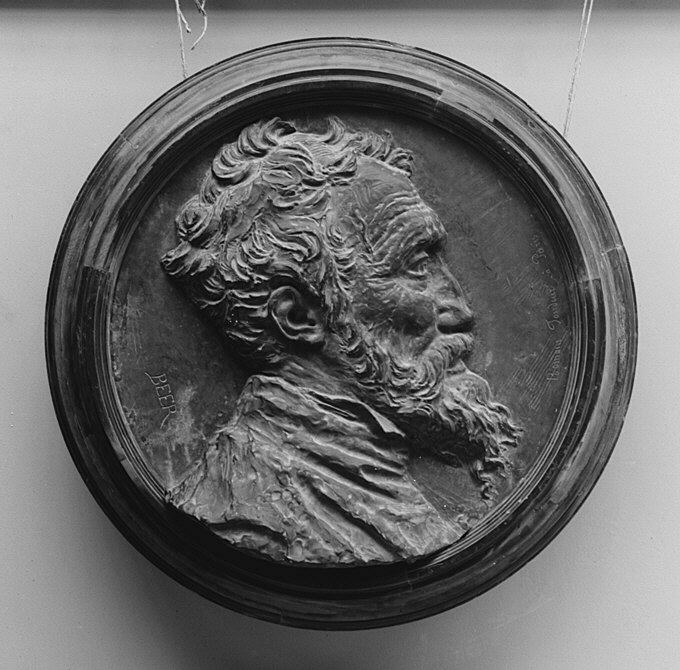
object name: portrait medallion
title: Michelangelo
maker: friedrich beer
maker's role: artist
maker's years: 1846-1912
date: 1801-1900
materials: bronze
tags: men,profiles